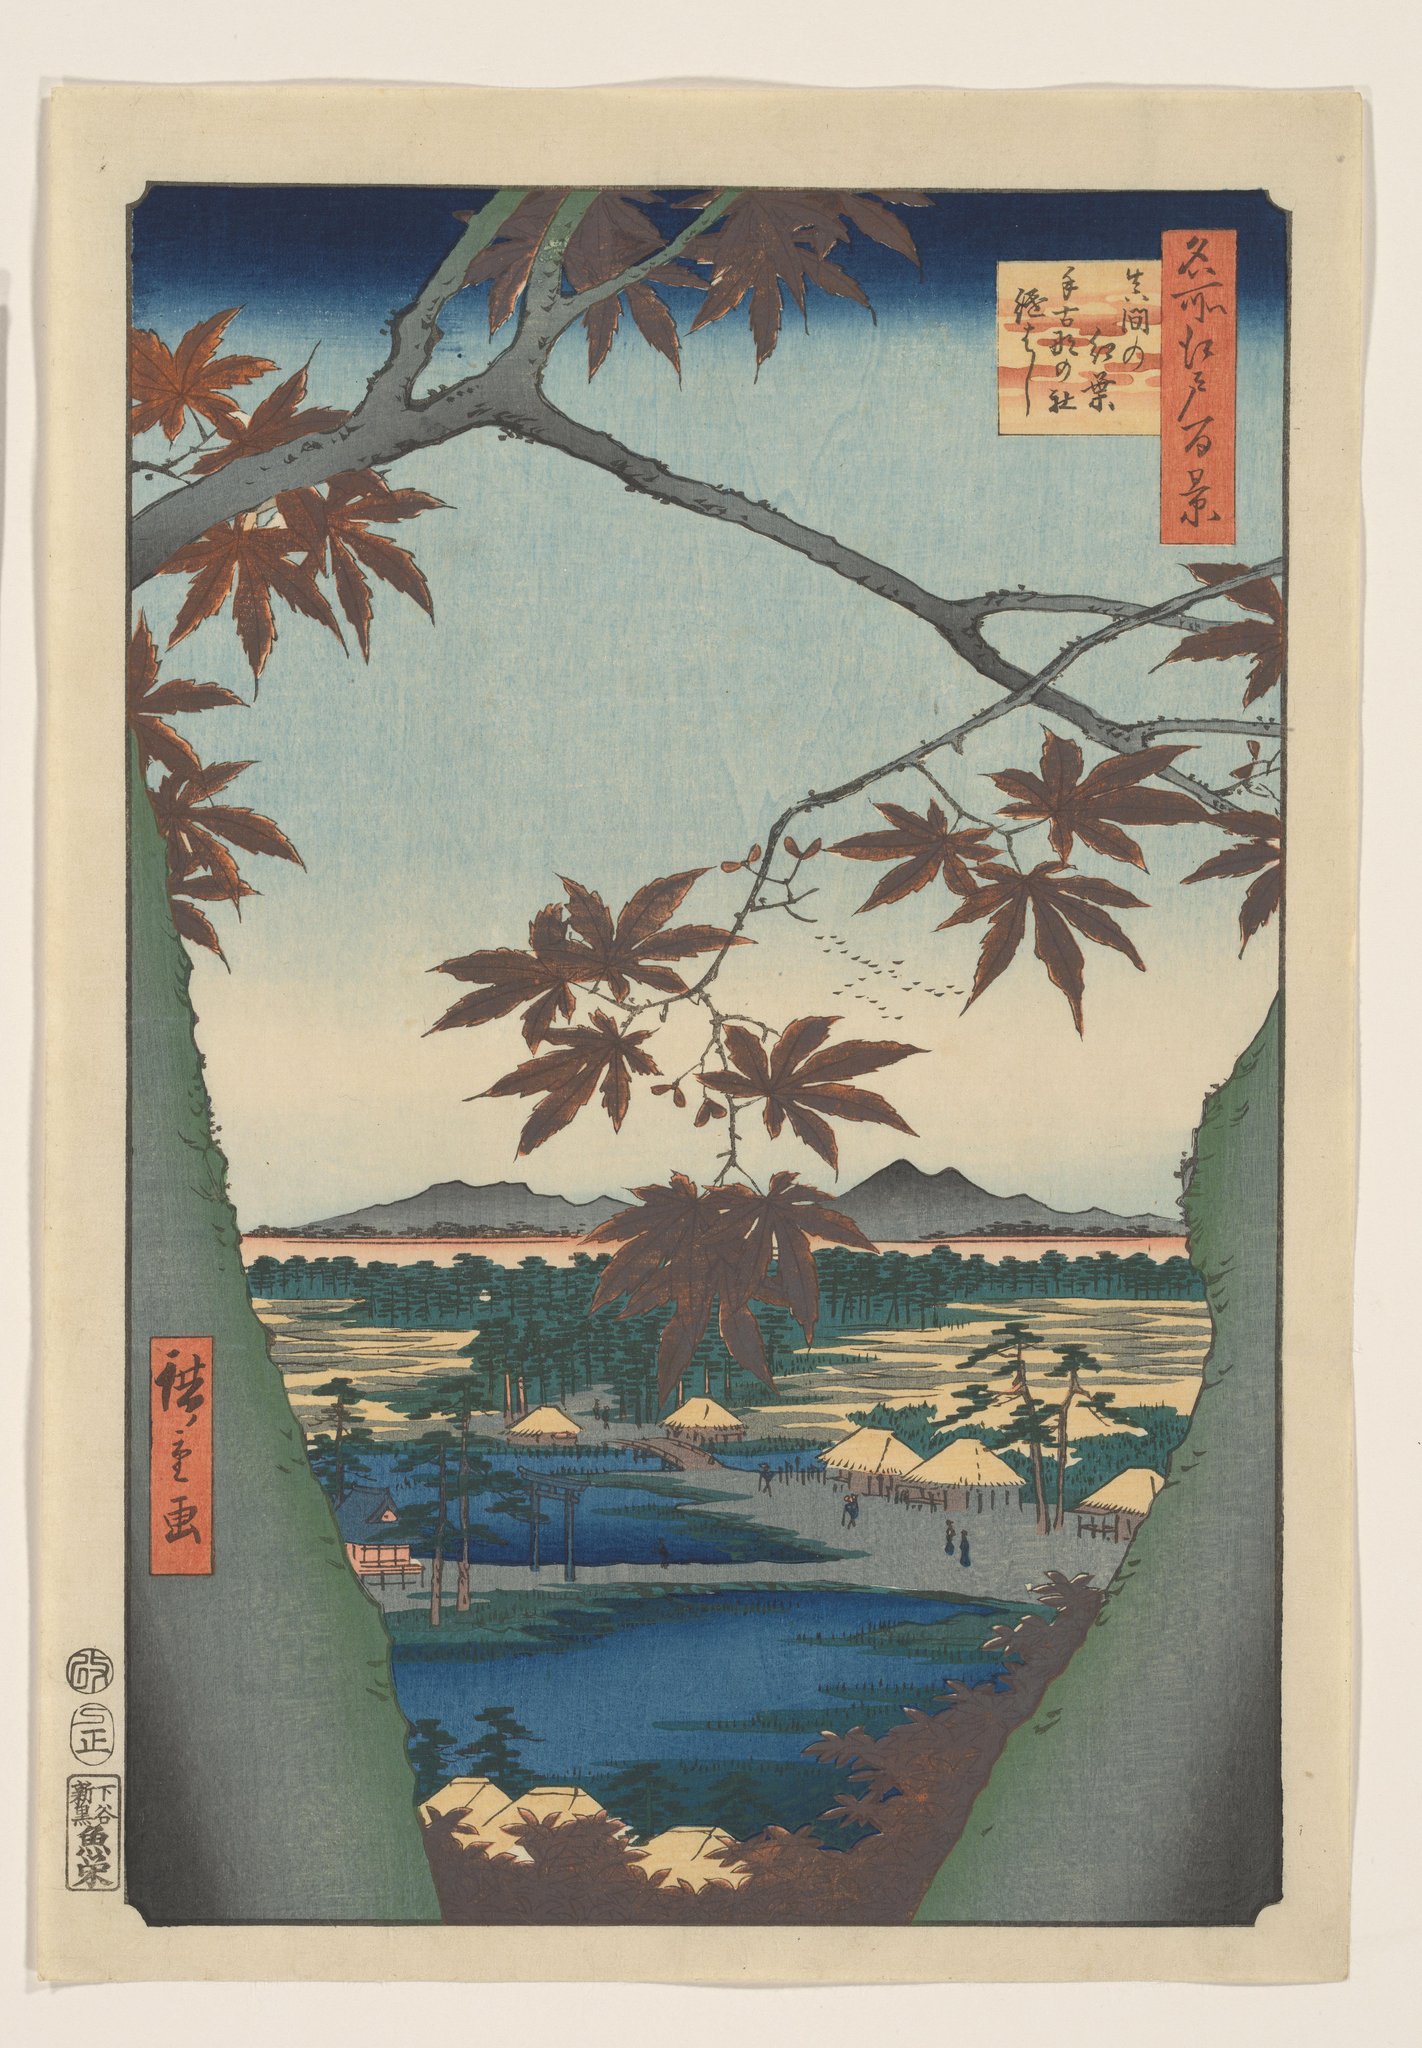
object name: print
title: Maple trees at Mama, Tekona shrine and the Linked bridge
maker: utagawa hiroshige (i)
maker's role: draughtsman, print maker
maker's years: 1797-1858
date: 1857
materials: paper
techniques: woodcut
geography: japan